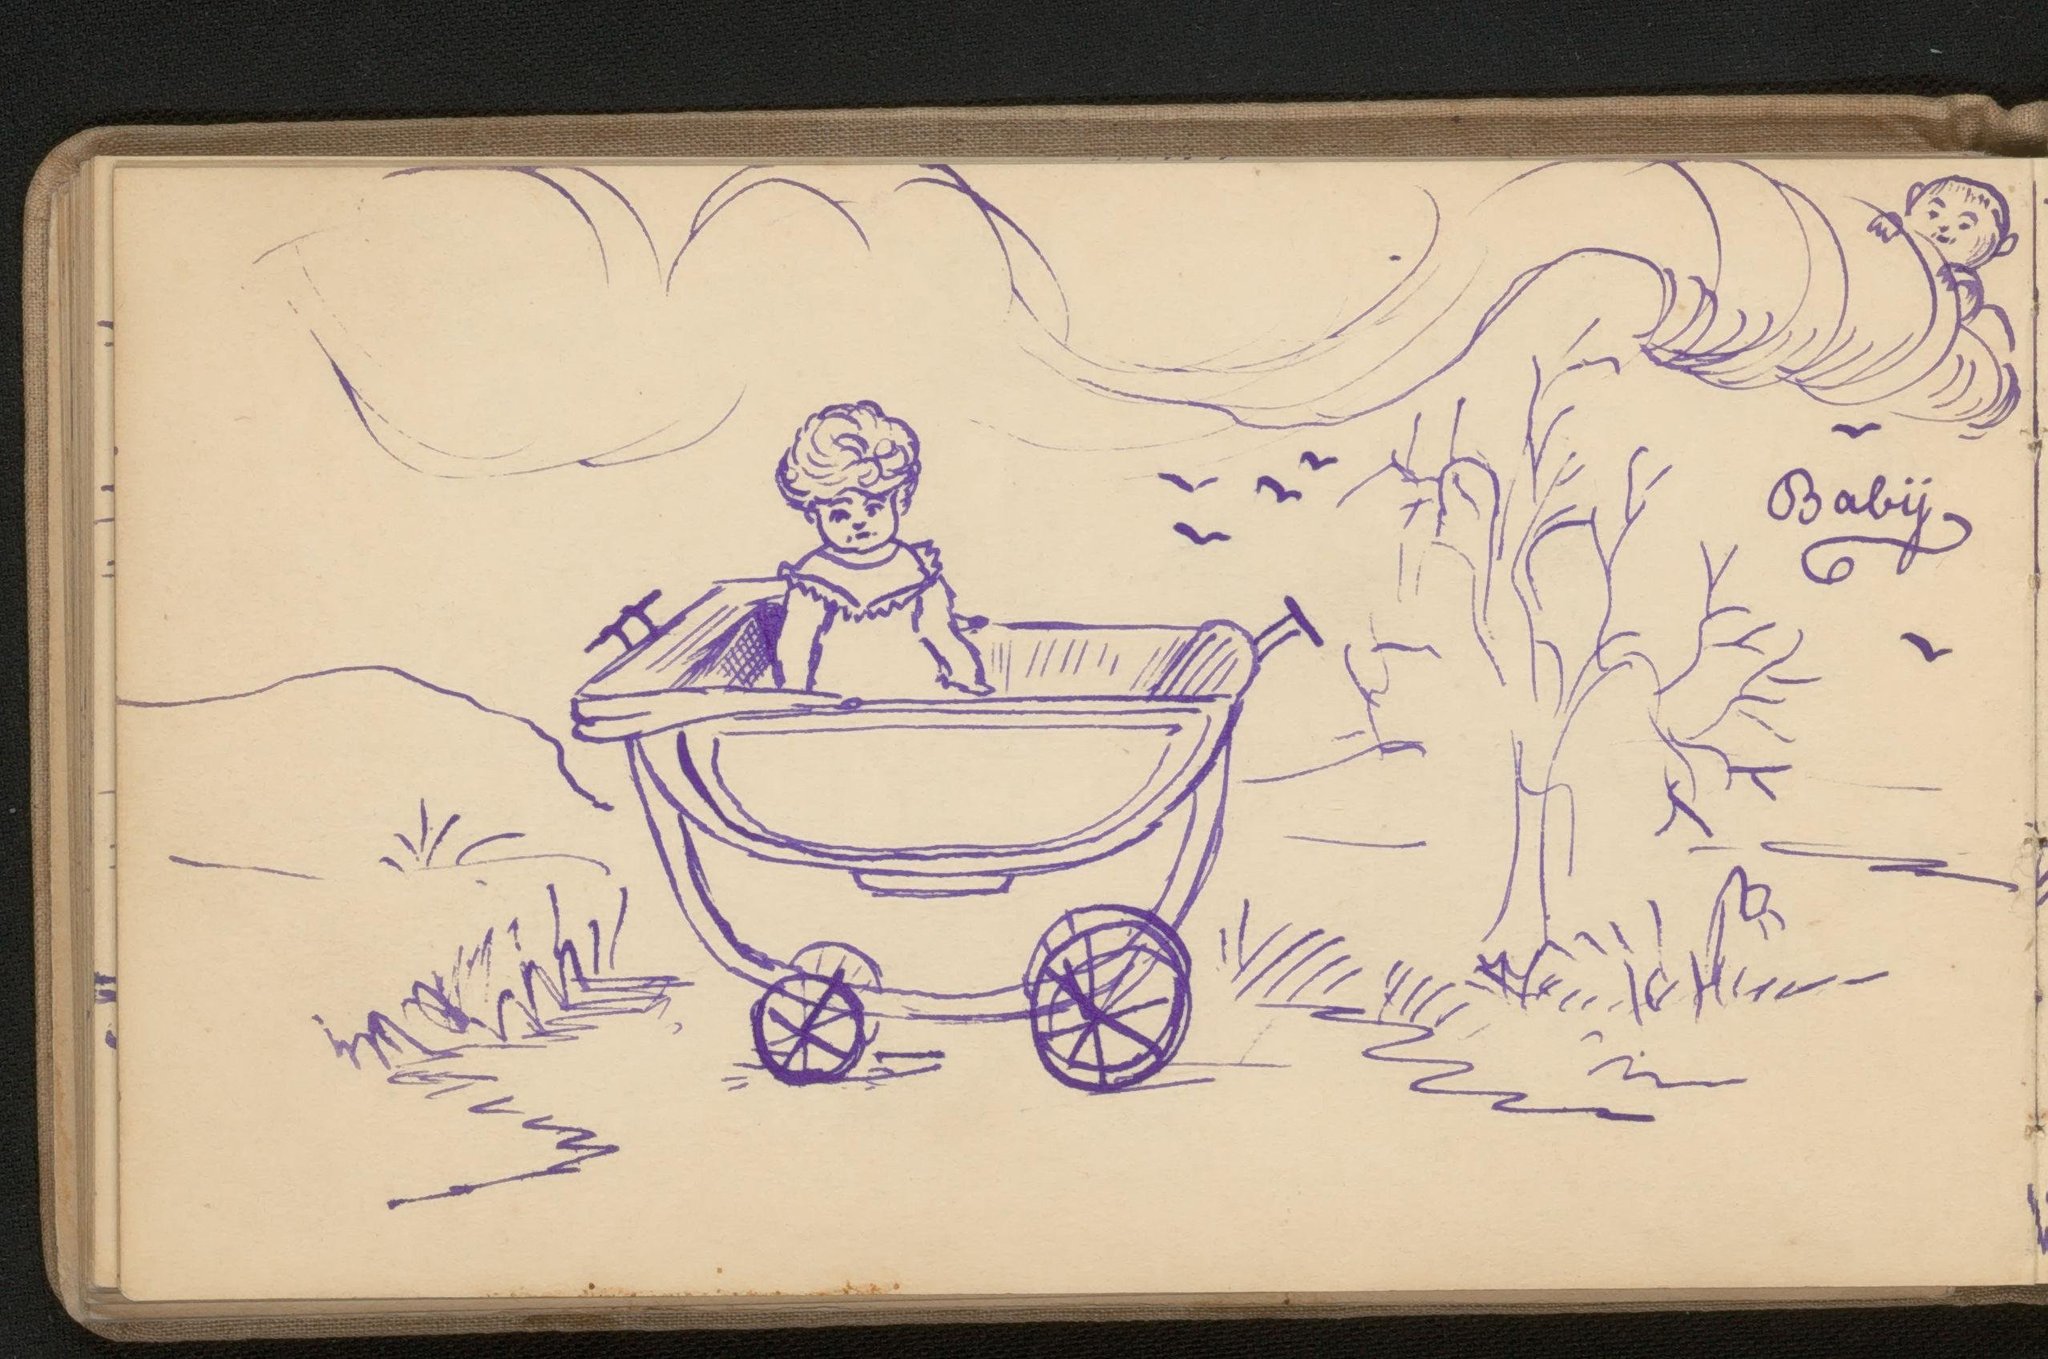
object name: sketchbook leaf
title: Baby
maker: Anonymous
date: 1875-1920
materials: ink, paper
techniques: pen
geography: netherlands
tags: baby-carriage, pram, perambulator, infant, baby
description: Baby buiten in de kinderwagen. Onderdeel van het schetsboek met humoristische tekeningen over het leven van een 'famille nombreuse'. Onderwerpsrubrieken binnen de Atlas Zeden en Gewoonten: Zeden en Gewoonten in Engeren Zin, Des menschen beging, midden en einde, Kinderleven.